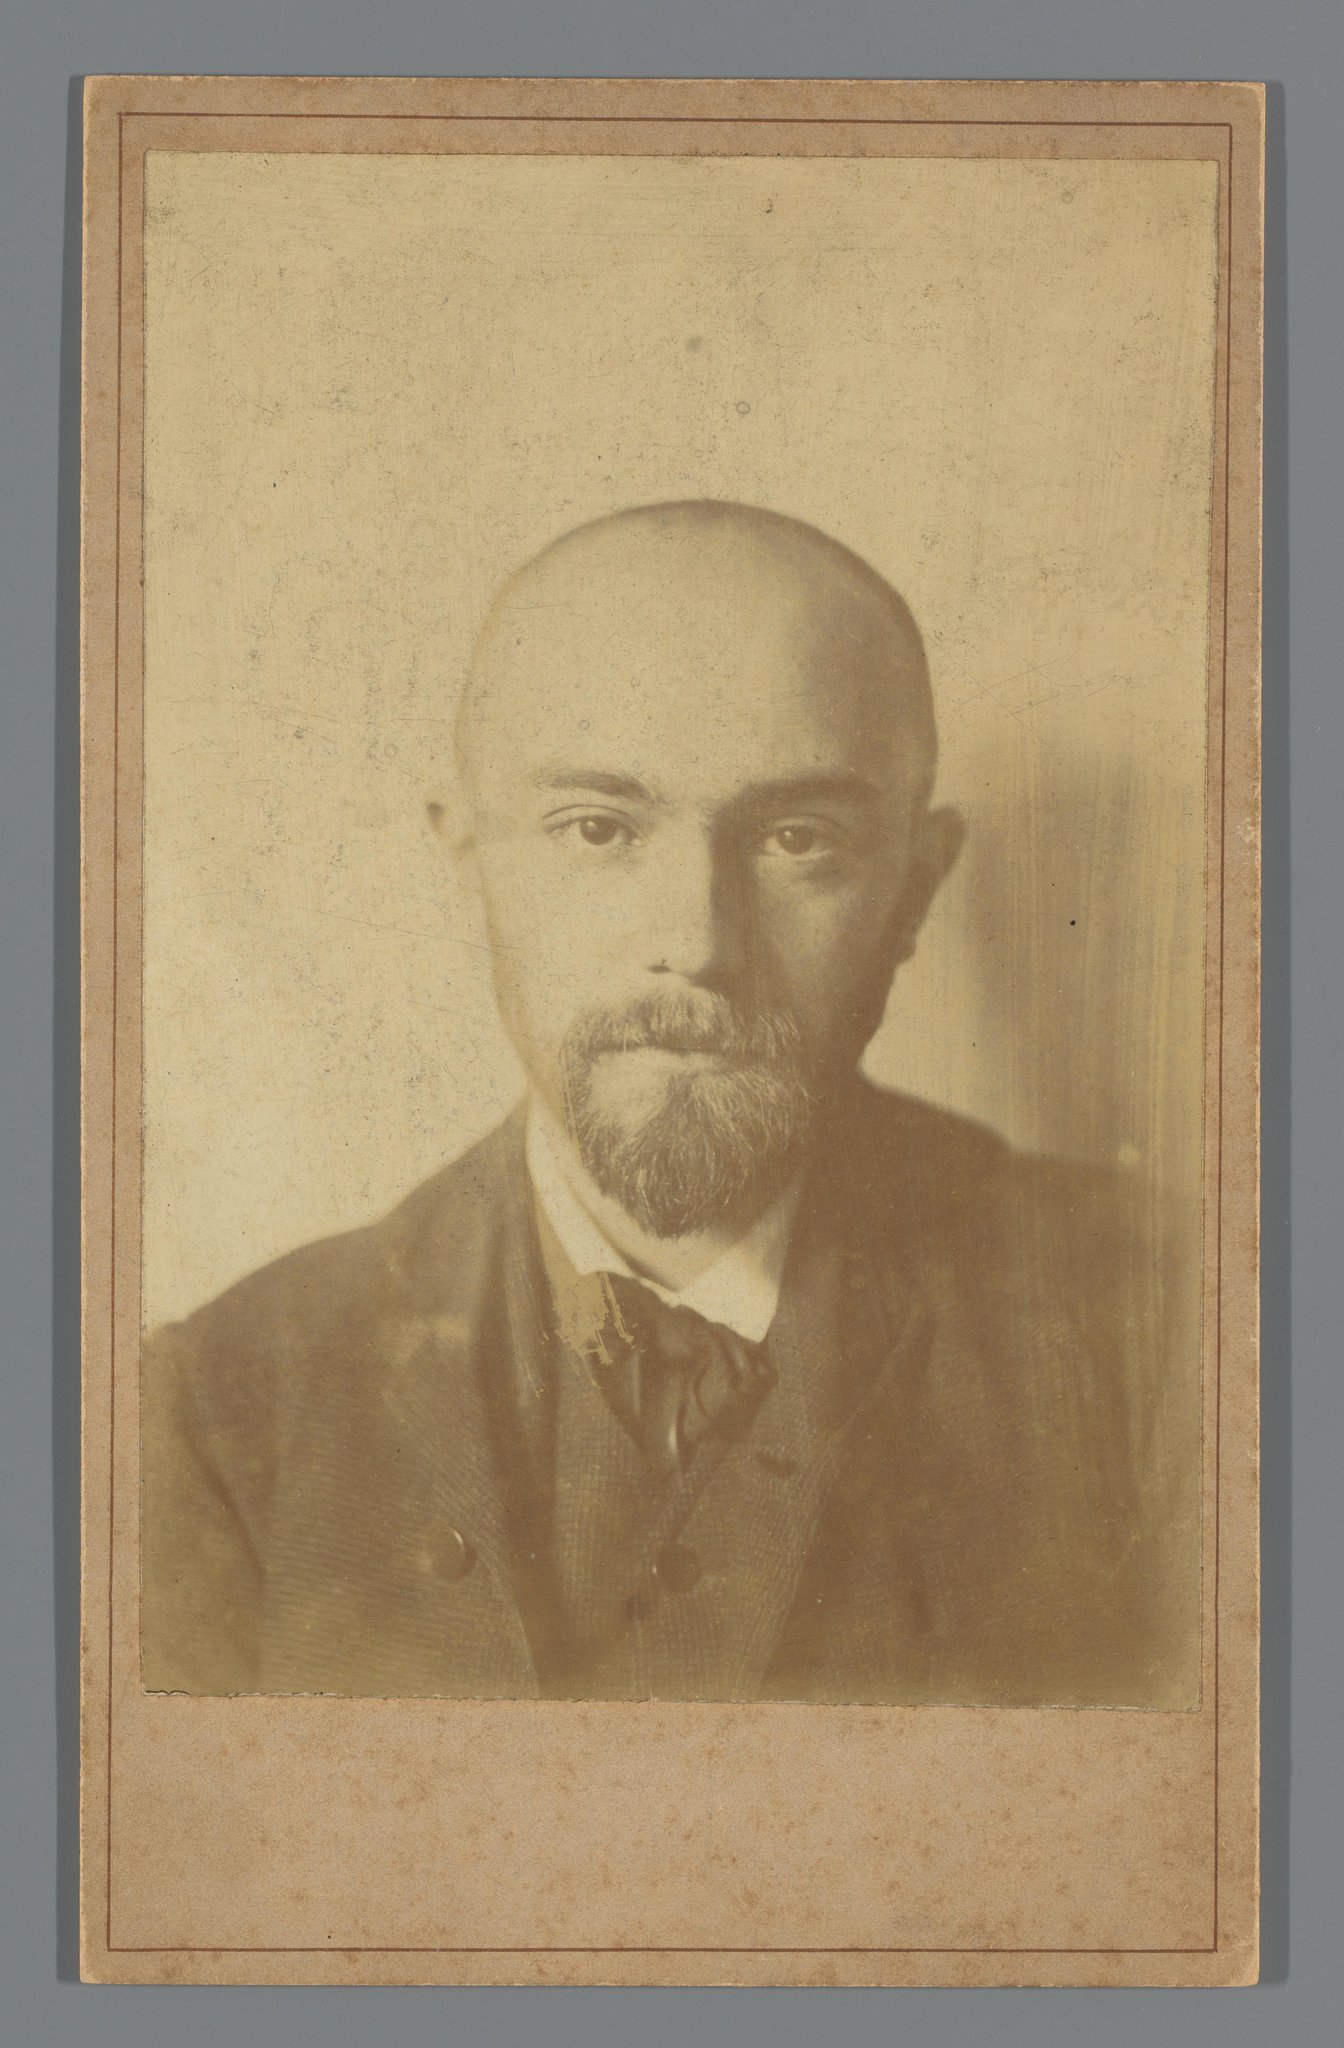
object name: photograph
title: Portret van Maurits van der Valk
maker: joseph jessurun de mesquita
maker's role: fotograaf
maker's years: 1865-1890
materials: cardboard, photographic support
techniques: gelatin silver print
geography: netherlands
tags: print maker, draughtsman, maurits van der valk, portrait, self-portrait of artist